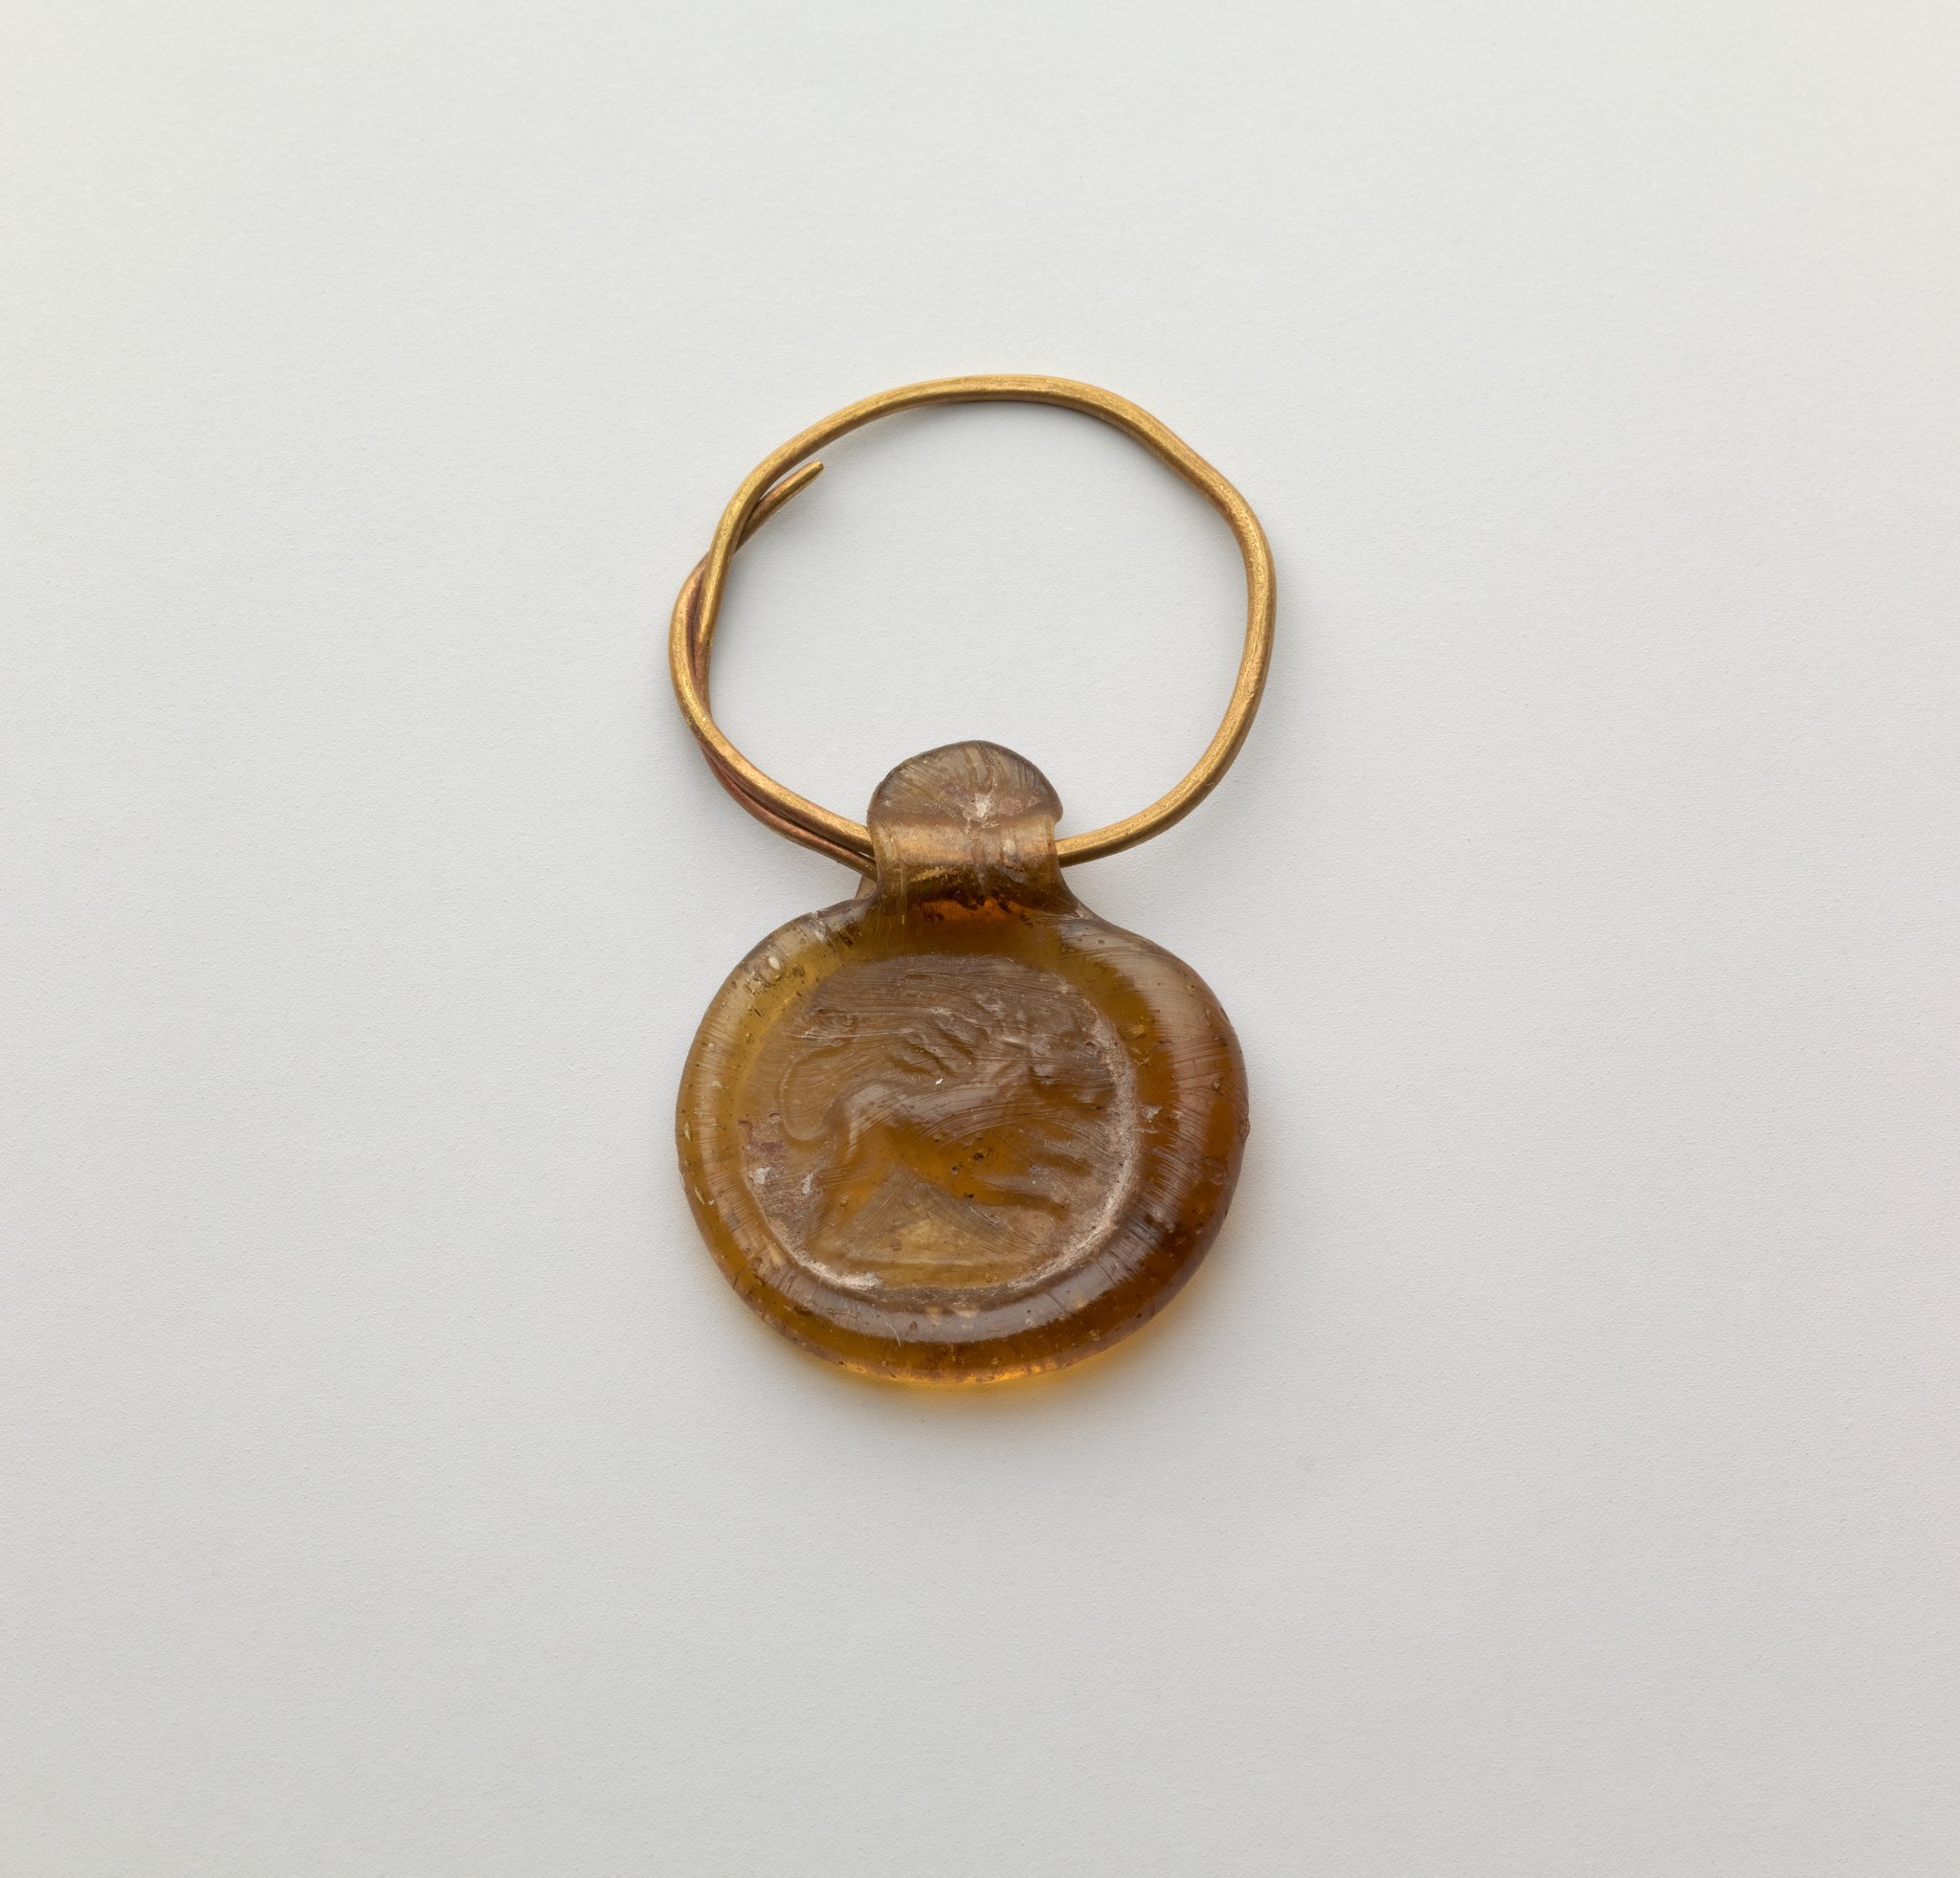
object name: pendant, stamped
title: Gold hoop with glass pendant stamped disk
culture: roman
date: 367-500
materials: glass, gold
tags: animals